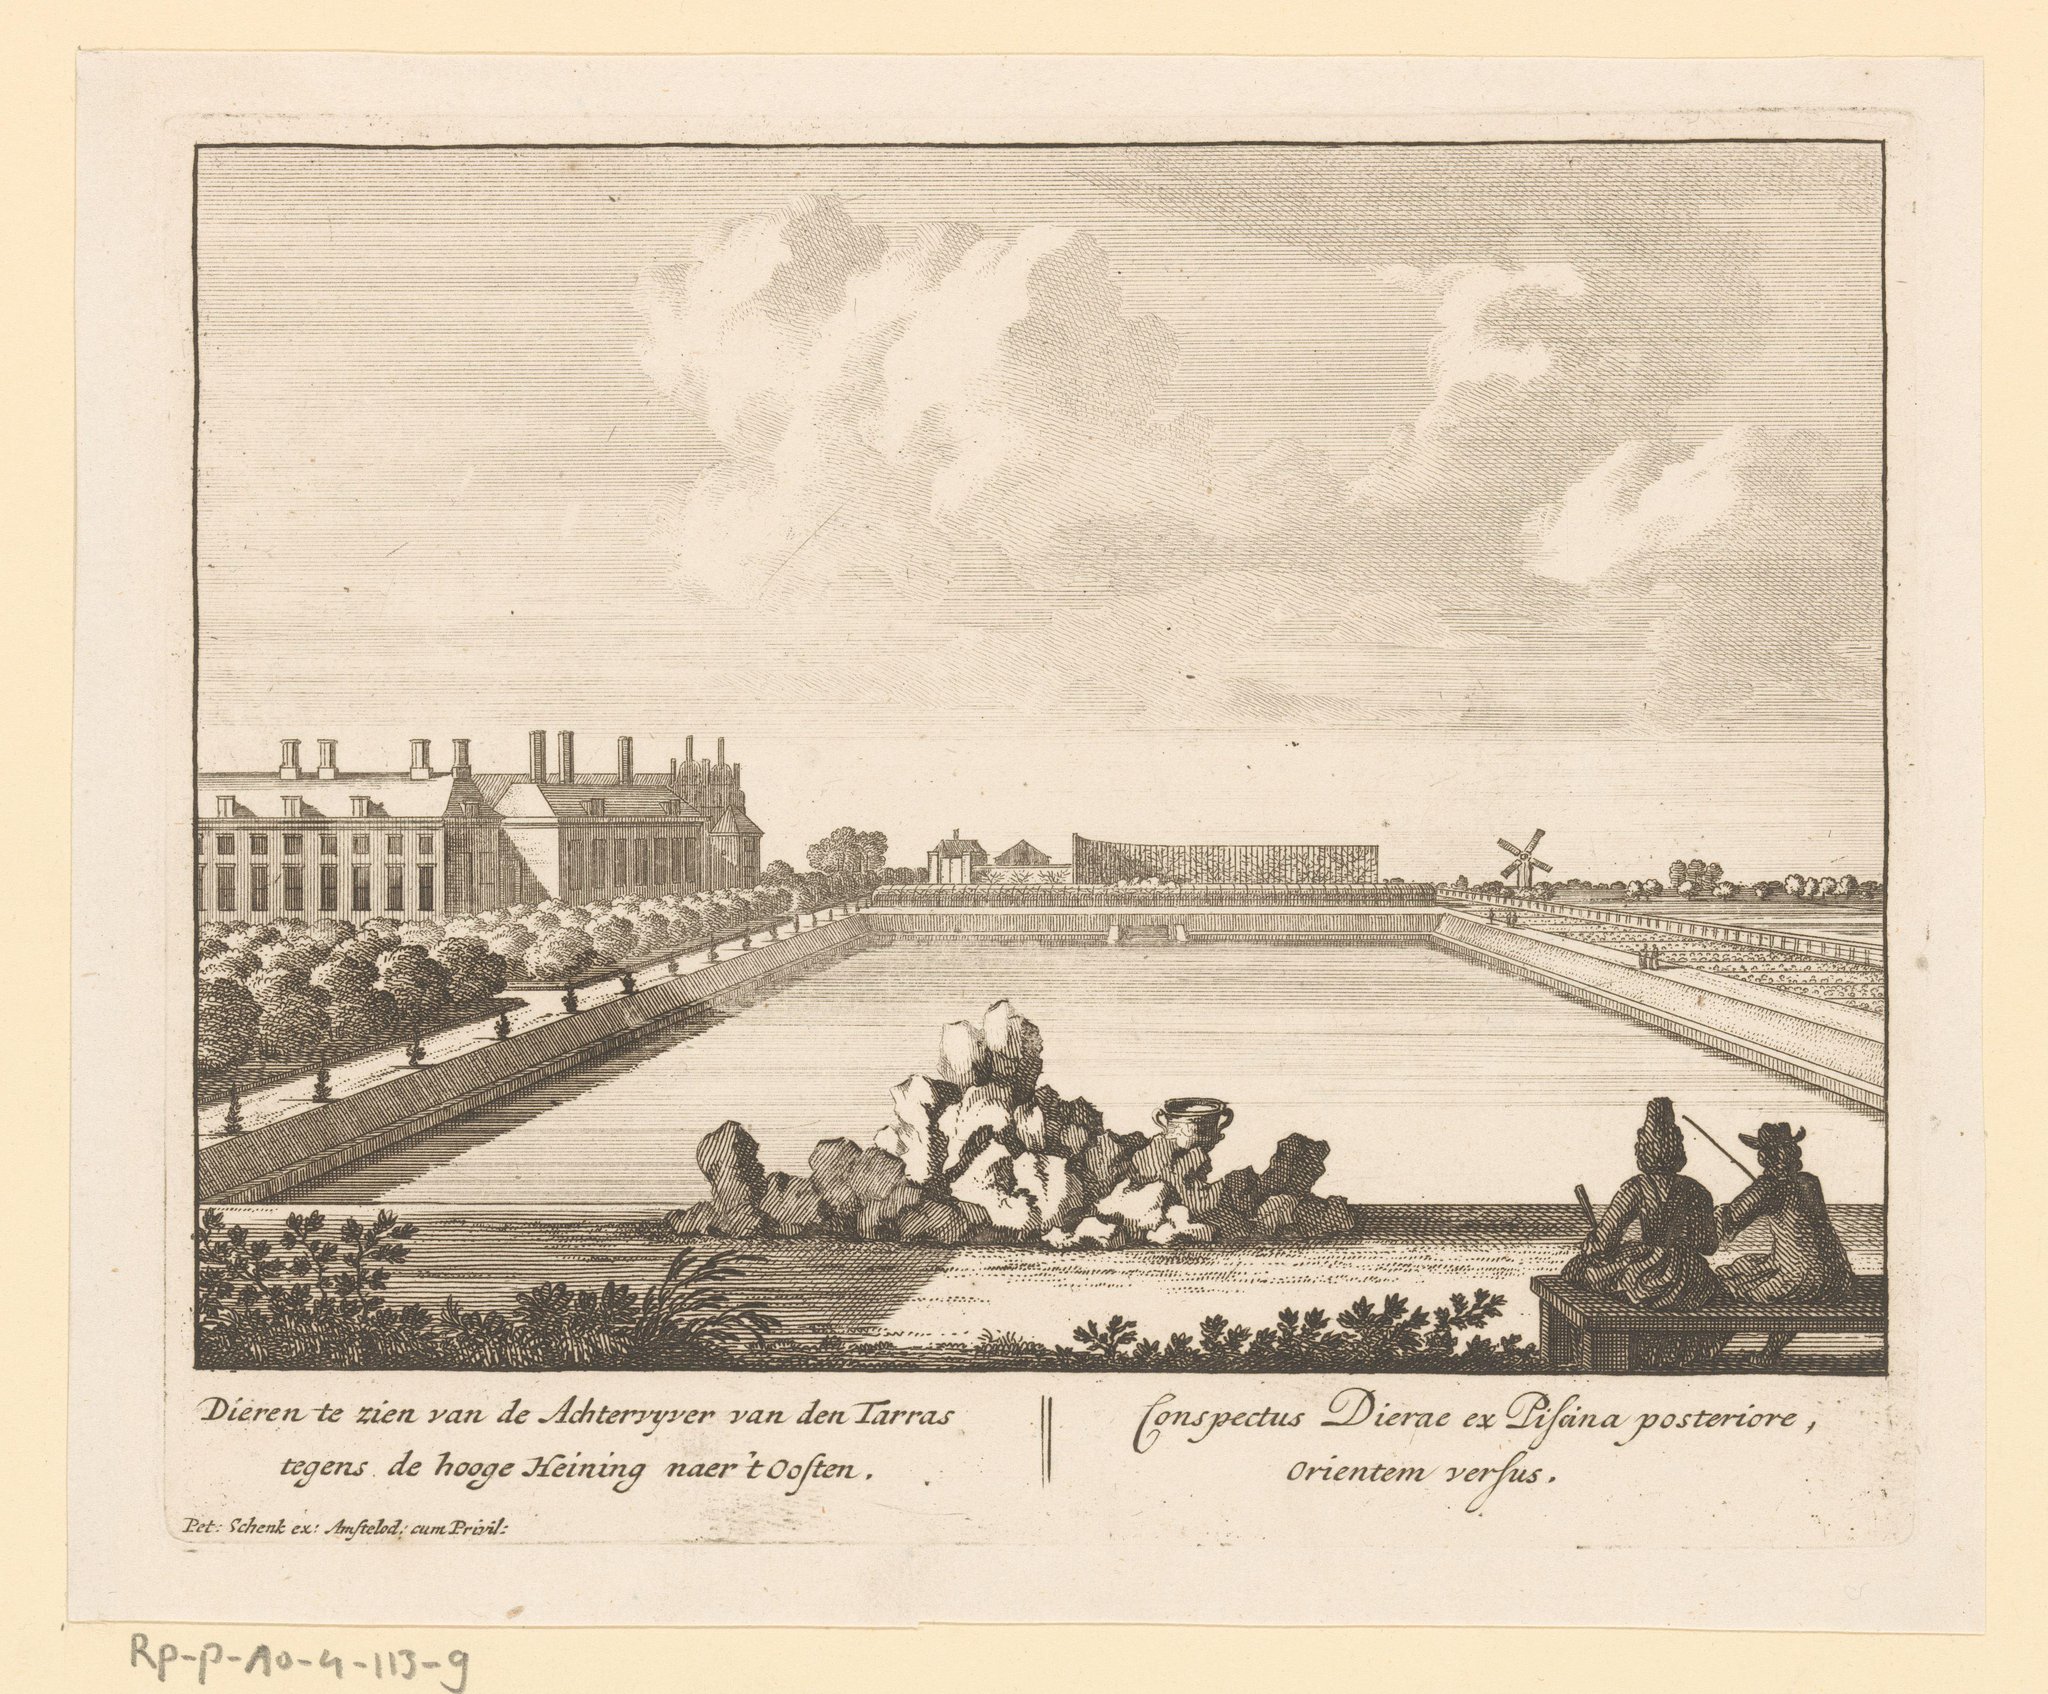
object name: print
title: Gezicht op het Hof te Dieren vanaf de achtervijver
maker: pieter schenk (i)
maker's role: print maker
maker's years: 1660-1711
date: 1700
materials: paper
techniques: engraving, etching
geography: amsterdam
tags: palace, french or architectonic garden; formal garden, garden pond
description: Prent is uitgeven door Pieter Schenk (I) als onderdeel van de zestiendelige prentserie 'Praetorium Dieranum', ca. 1700. Later is de prent ook gebruikt in: Schenk, Pieter (I). Paradisus Oculorum: sive conspectus degantissimi centum (...). Jacobus Romanus, ca. 1700.